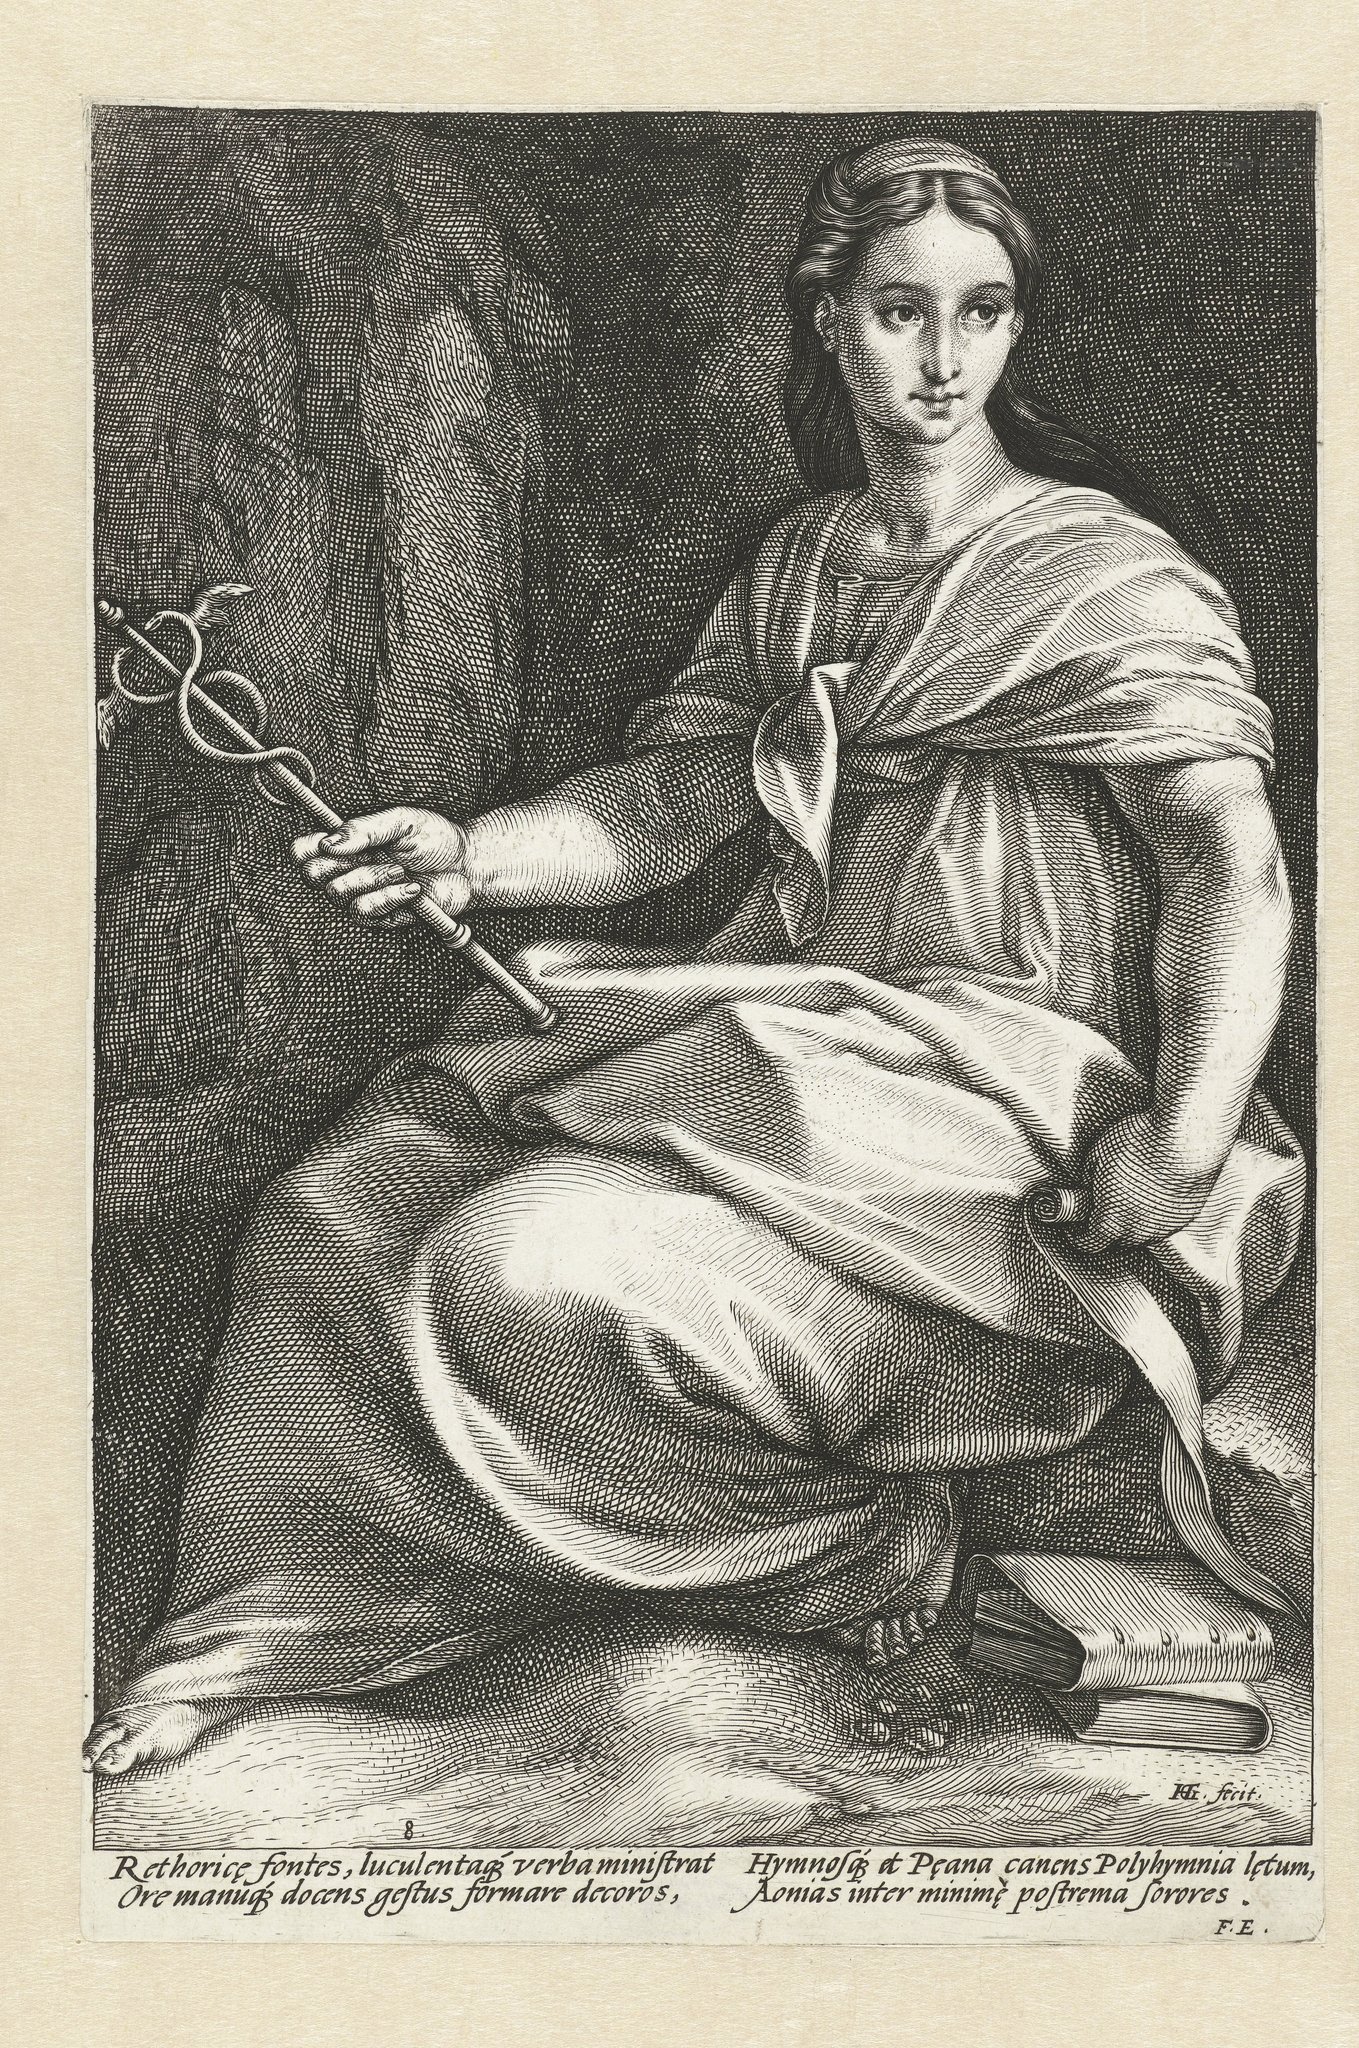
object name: print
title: Polyhymnia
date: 1592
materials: paper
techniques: engraving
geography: haarlem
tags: polyhymnia (one of the muses); 'polinnia' (ripa)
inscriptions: collector's mark: Lugt 2228a, signature: ‘HG. fecit.’, signature: ‘F.E.’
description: Een serie van negen muzen. Vier regels Latijn van Franco Estius in marge onder prent.